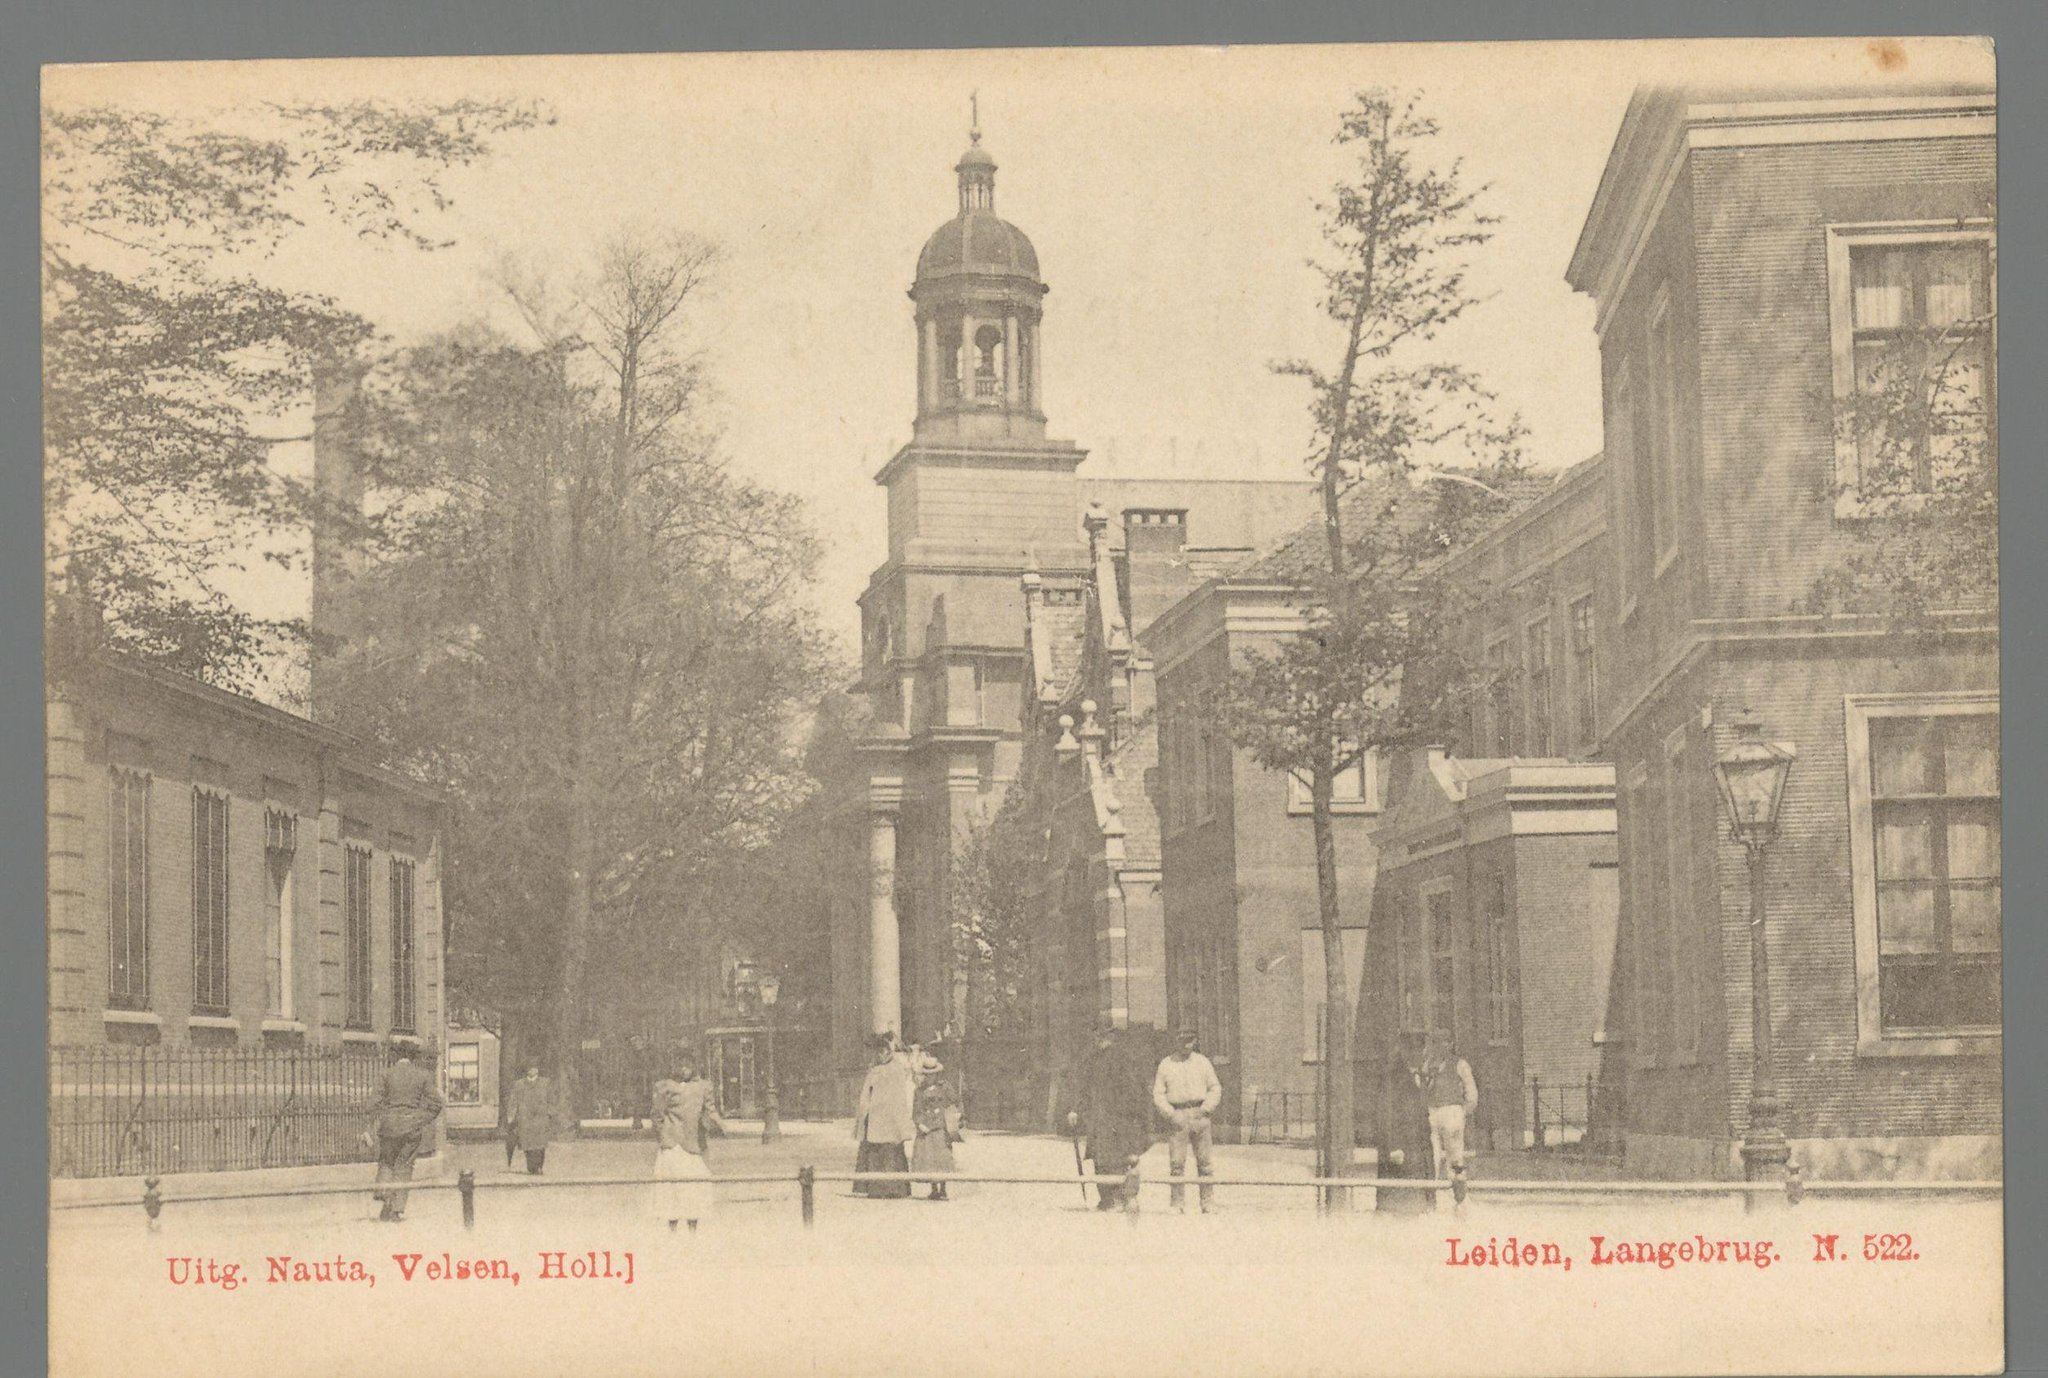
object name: photomechanical print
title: Leiden, Langebrug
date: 1897-1905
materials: cardboard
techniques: photograph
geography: velsen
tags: church (exterior), street